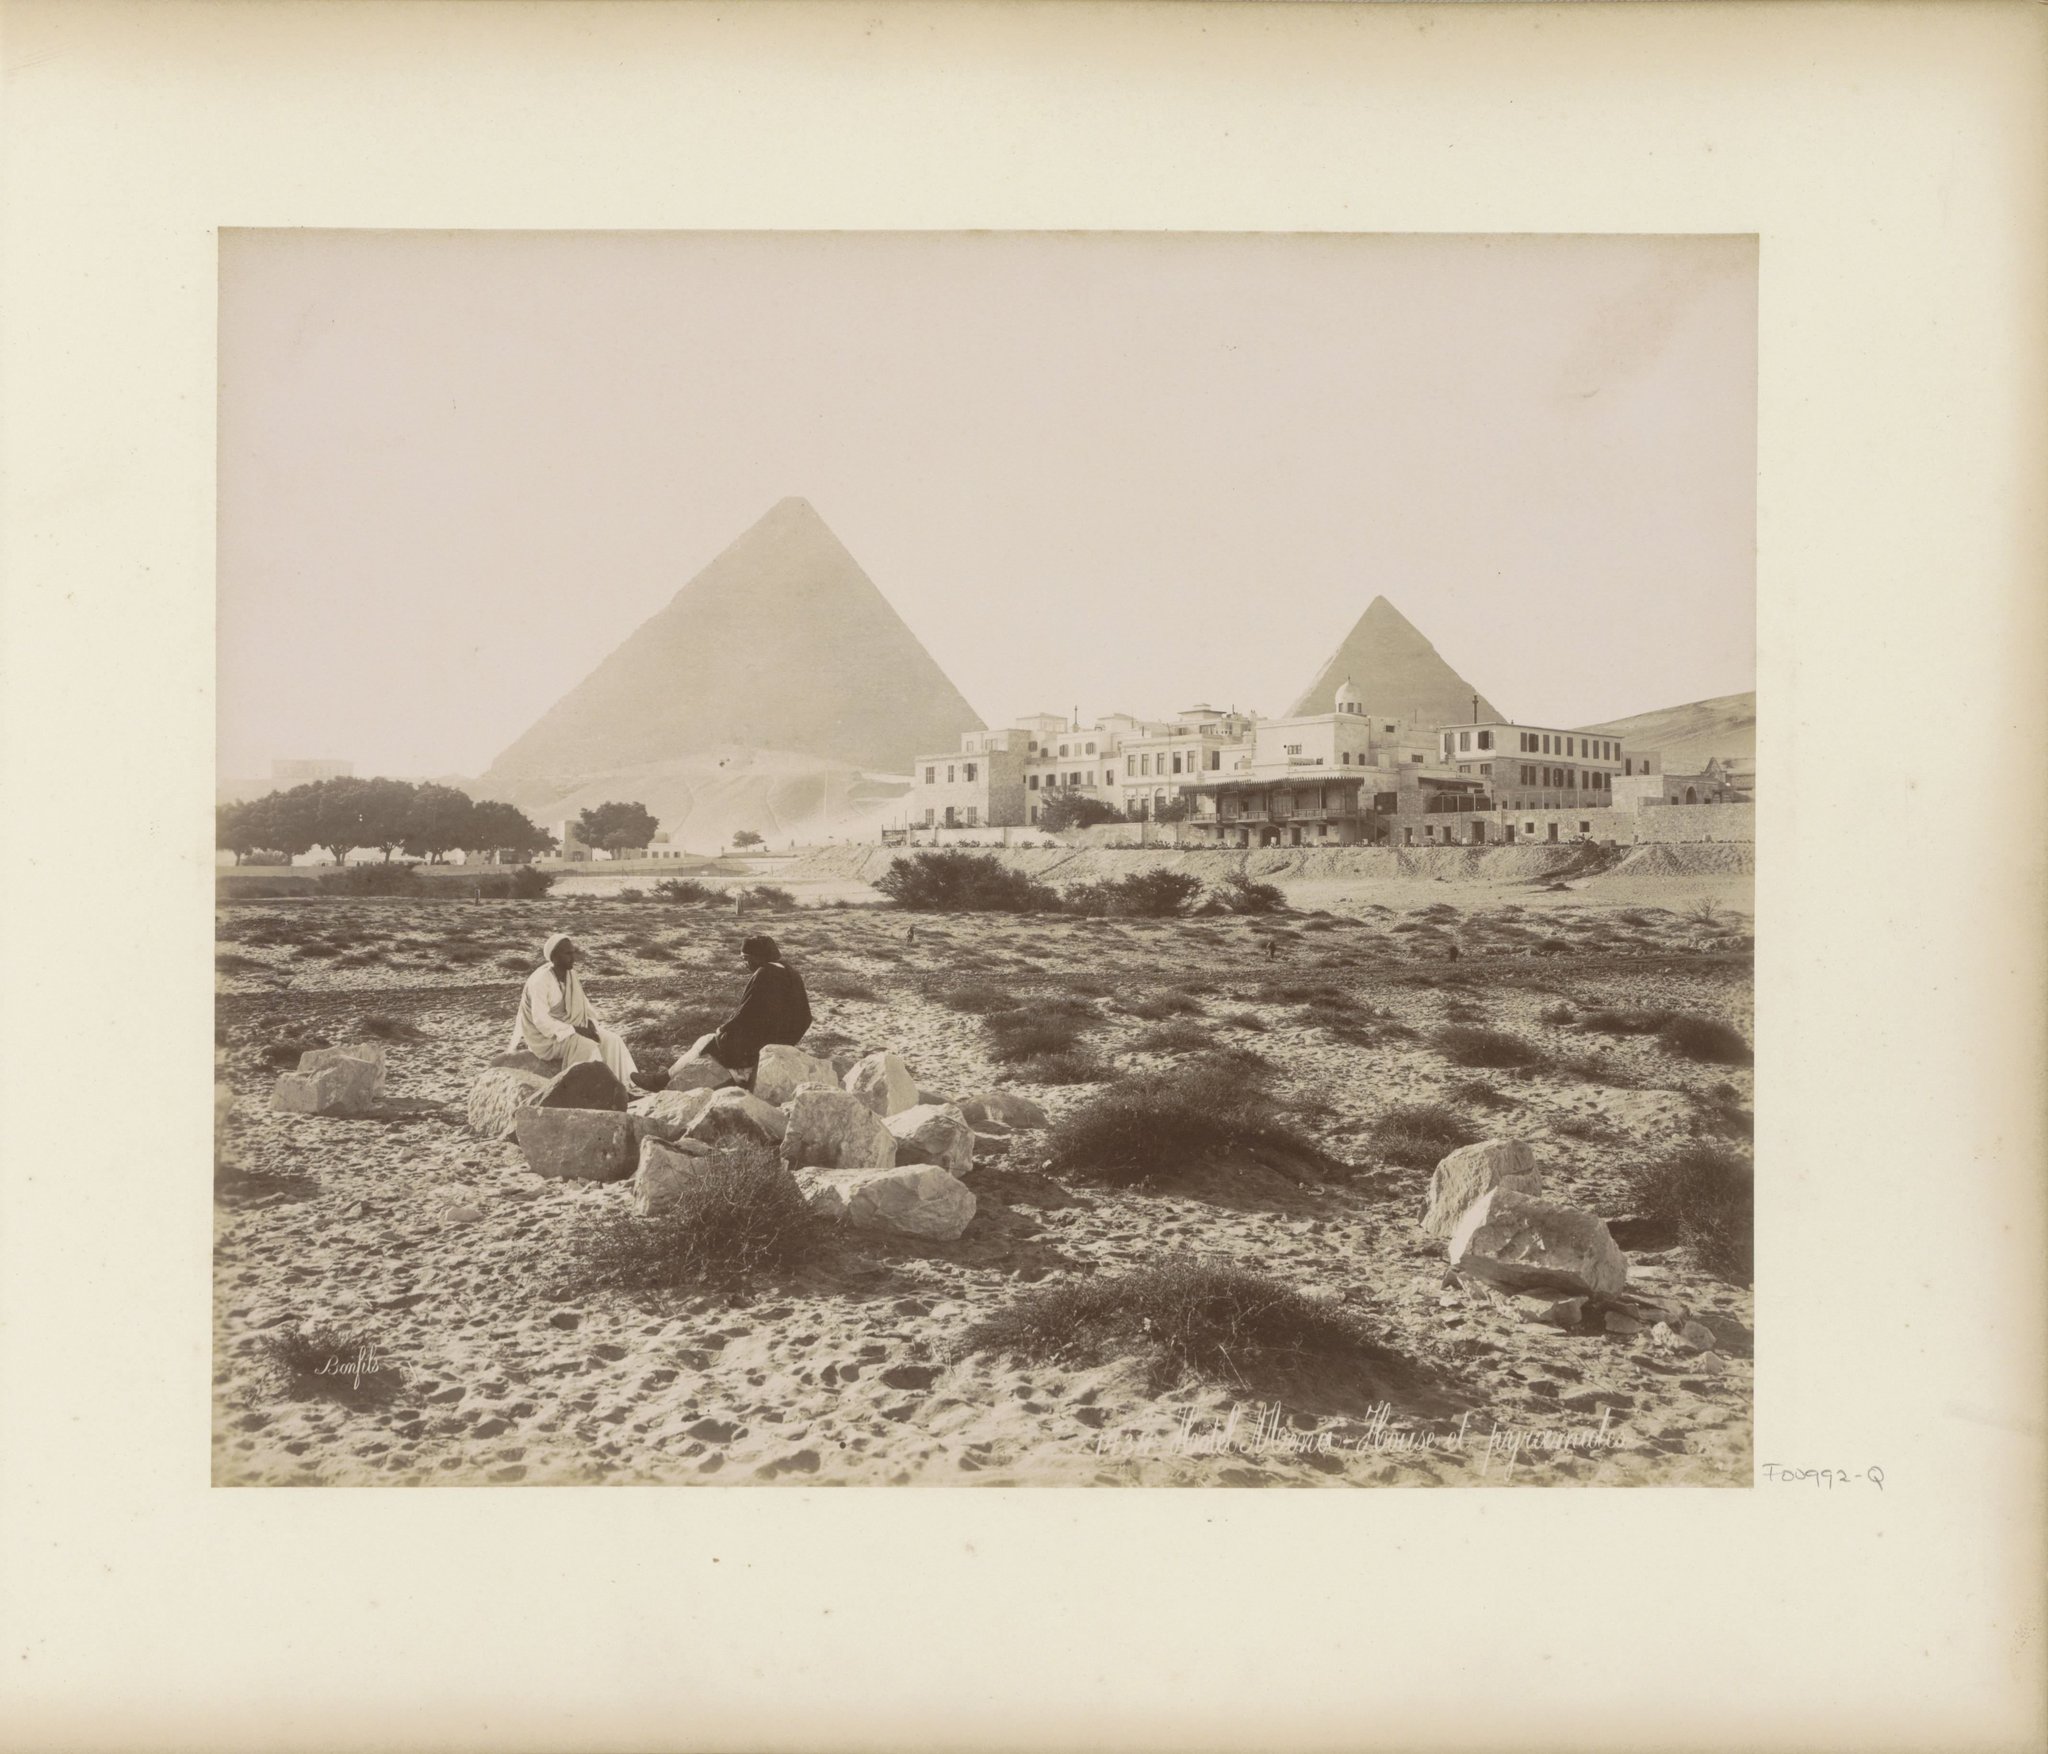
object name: photograph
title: Gezicht op de piramides van Gizeh met op de voorgrond hotel 'Mena House'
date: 1886-1898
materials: cardboard, paper, photographic support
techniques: albumen print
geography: gizeh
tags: pyramid (historical grave form), hotel, hostelry, inn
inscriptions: negative number: ‘1434’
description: Onderdeel van Reisalbum met 80 foto's van Egypte.